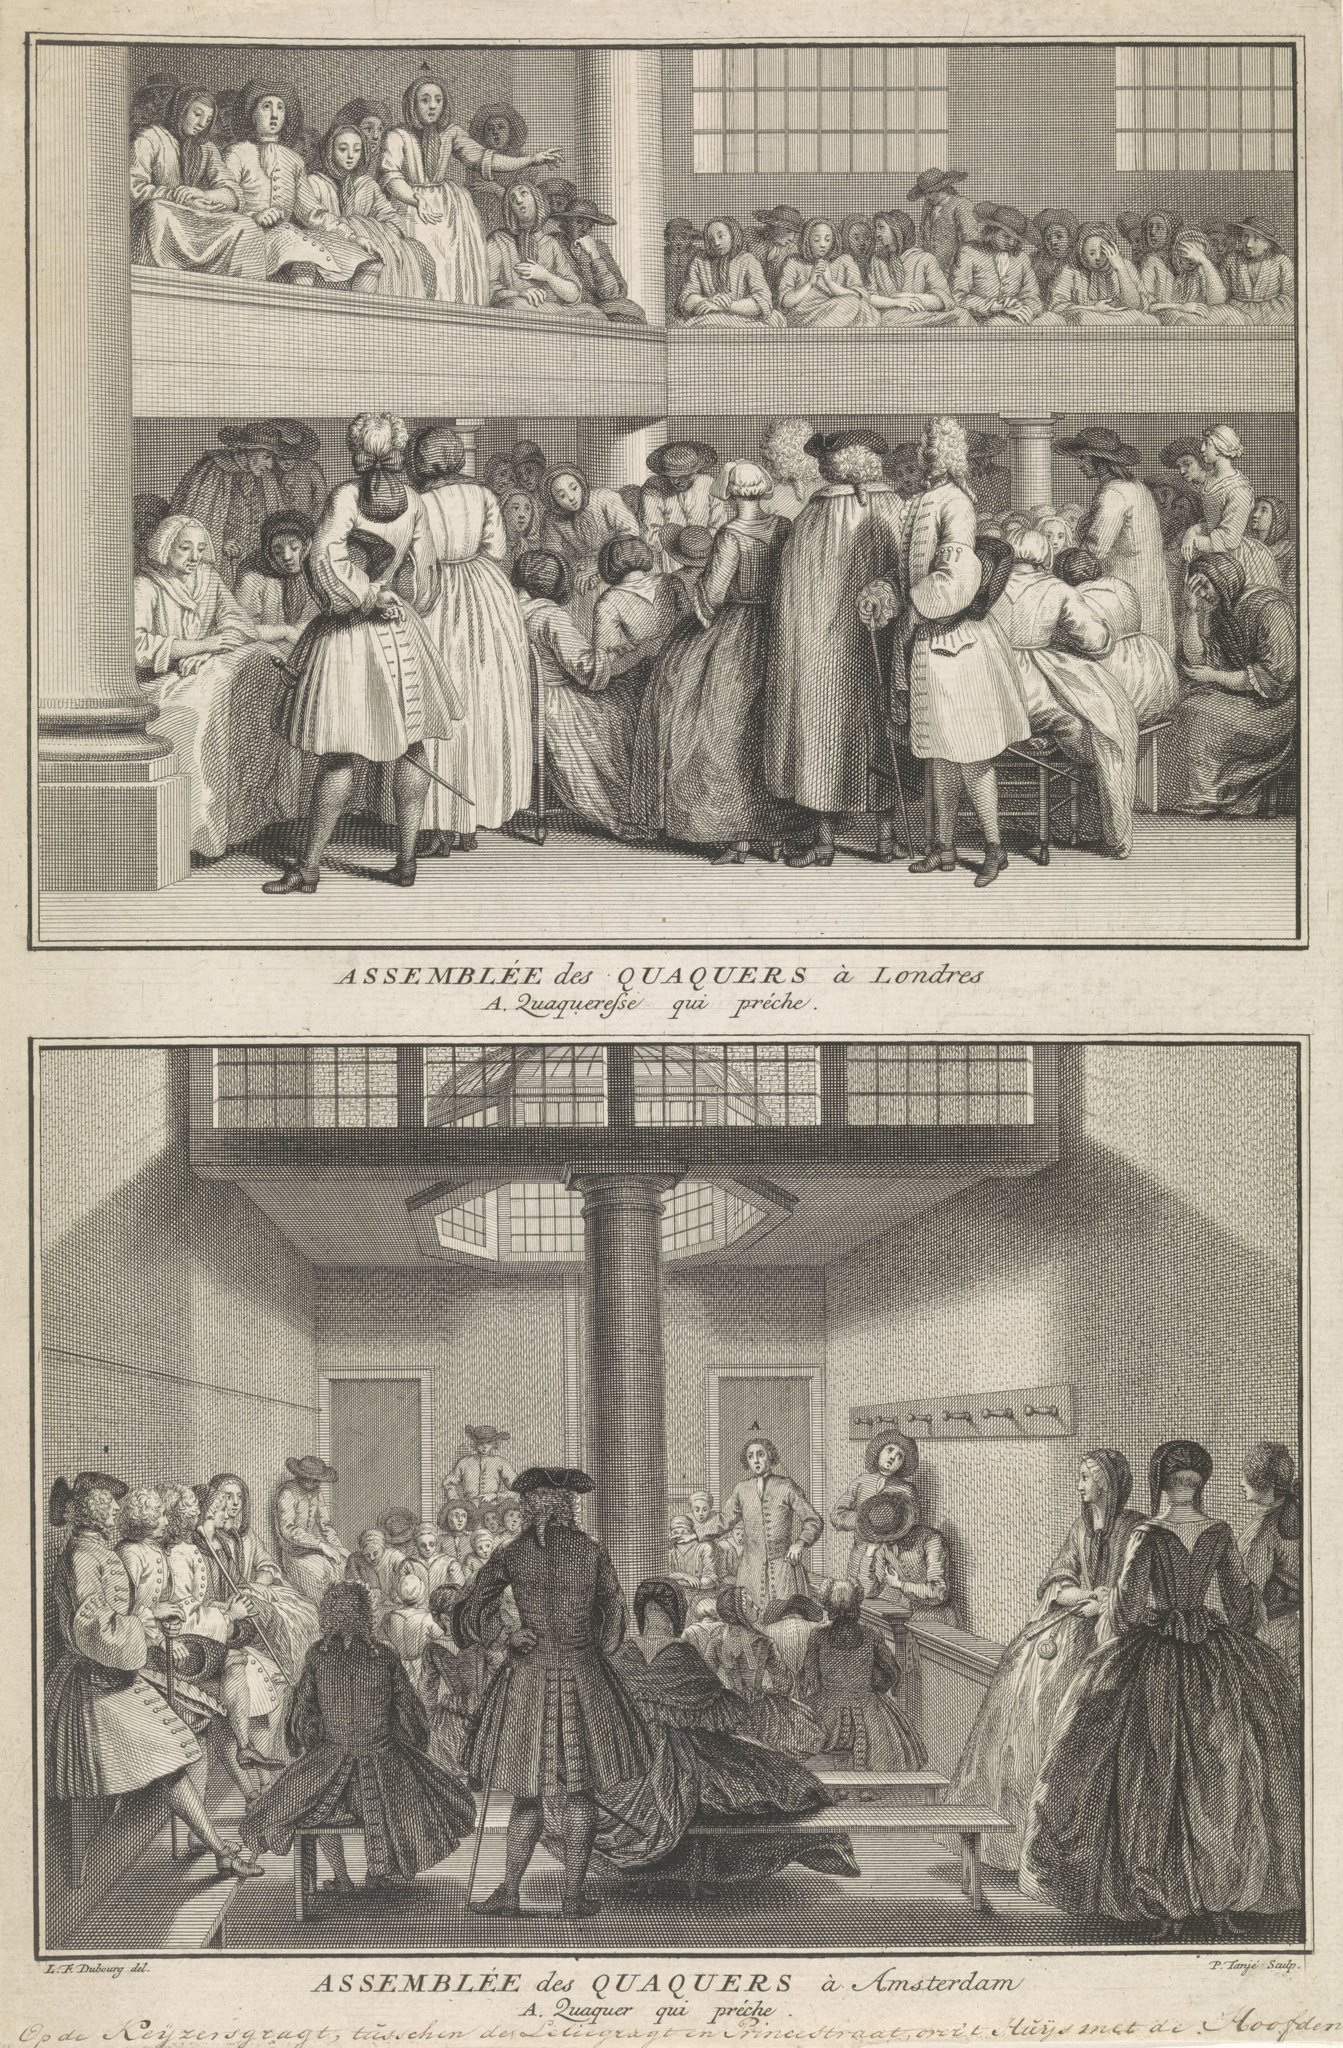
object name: book illustration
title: Quakers vergaderingen te Londen en Amsterdam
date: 1736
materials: paper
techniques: engraving, etching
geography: amsterdam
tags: protestant churches and denominations (with name)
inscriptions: collector's mark: Lugt 2228, inscription: ‘Op de Keijzersgragt, tusschende Leliegragt en Princestraat, over 't Huys met de Hoofden’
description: Twee voorstellingen op een blad. Boven: een vergadering van de quakers in Londen. Mannen en vrouwen zijn in een kerkzaal bijeen, en zitten beneden en op het balkon. Onder: een vergadering van quakers in Amsterdam.